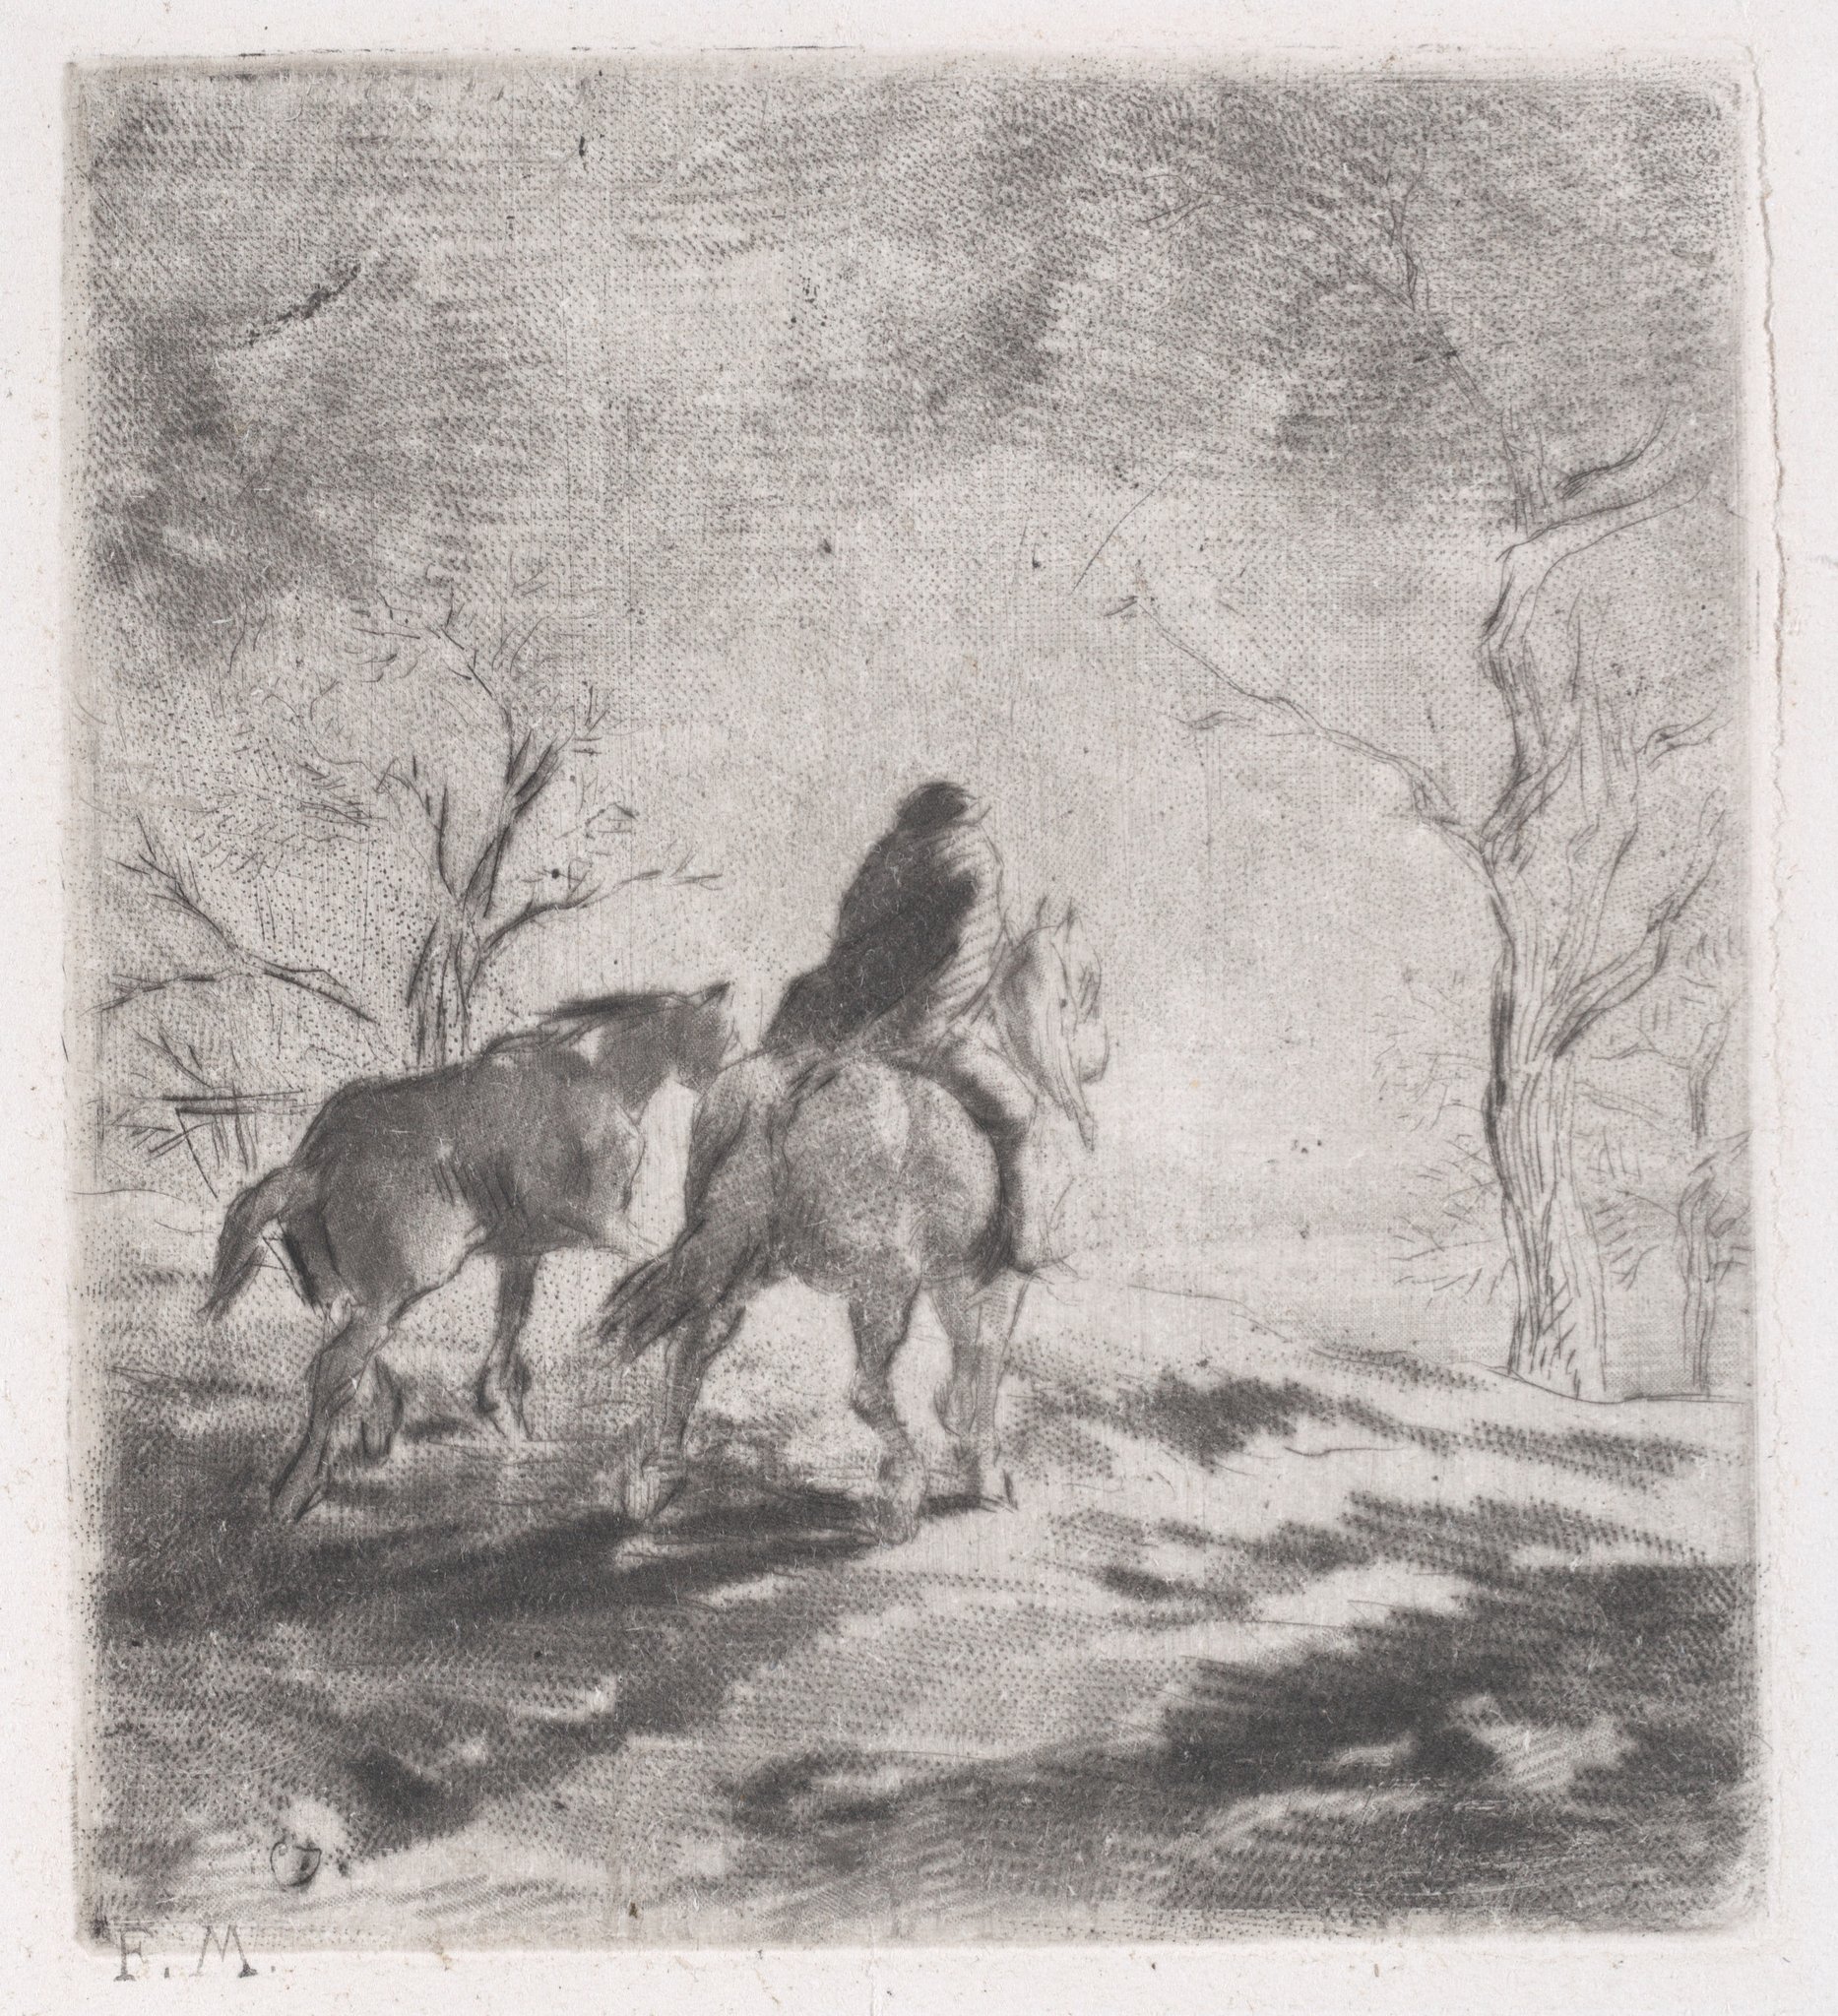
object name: print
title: The Watering Hole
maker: charles émile jacque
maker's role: artist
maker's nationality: french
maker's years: 1813-1894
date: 1848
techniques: drypoint, roulette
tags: horses